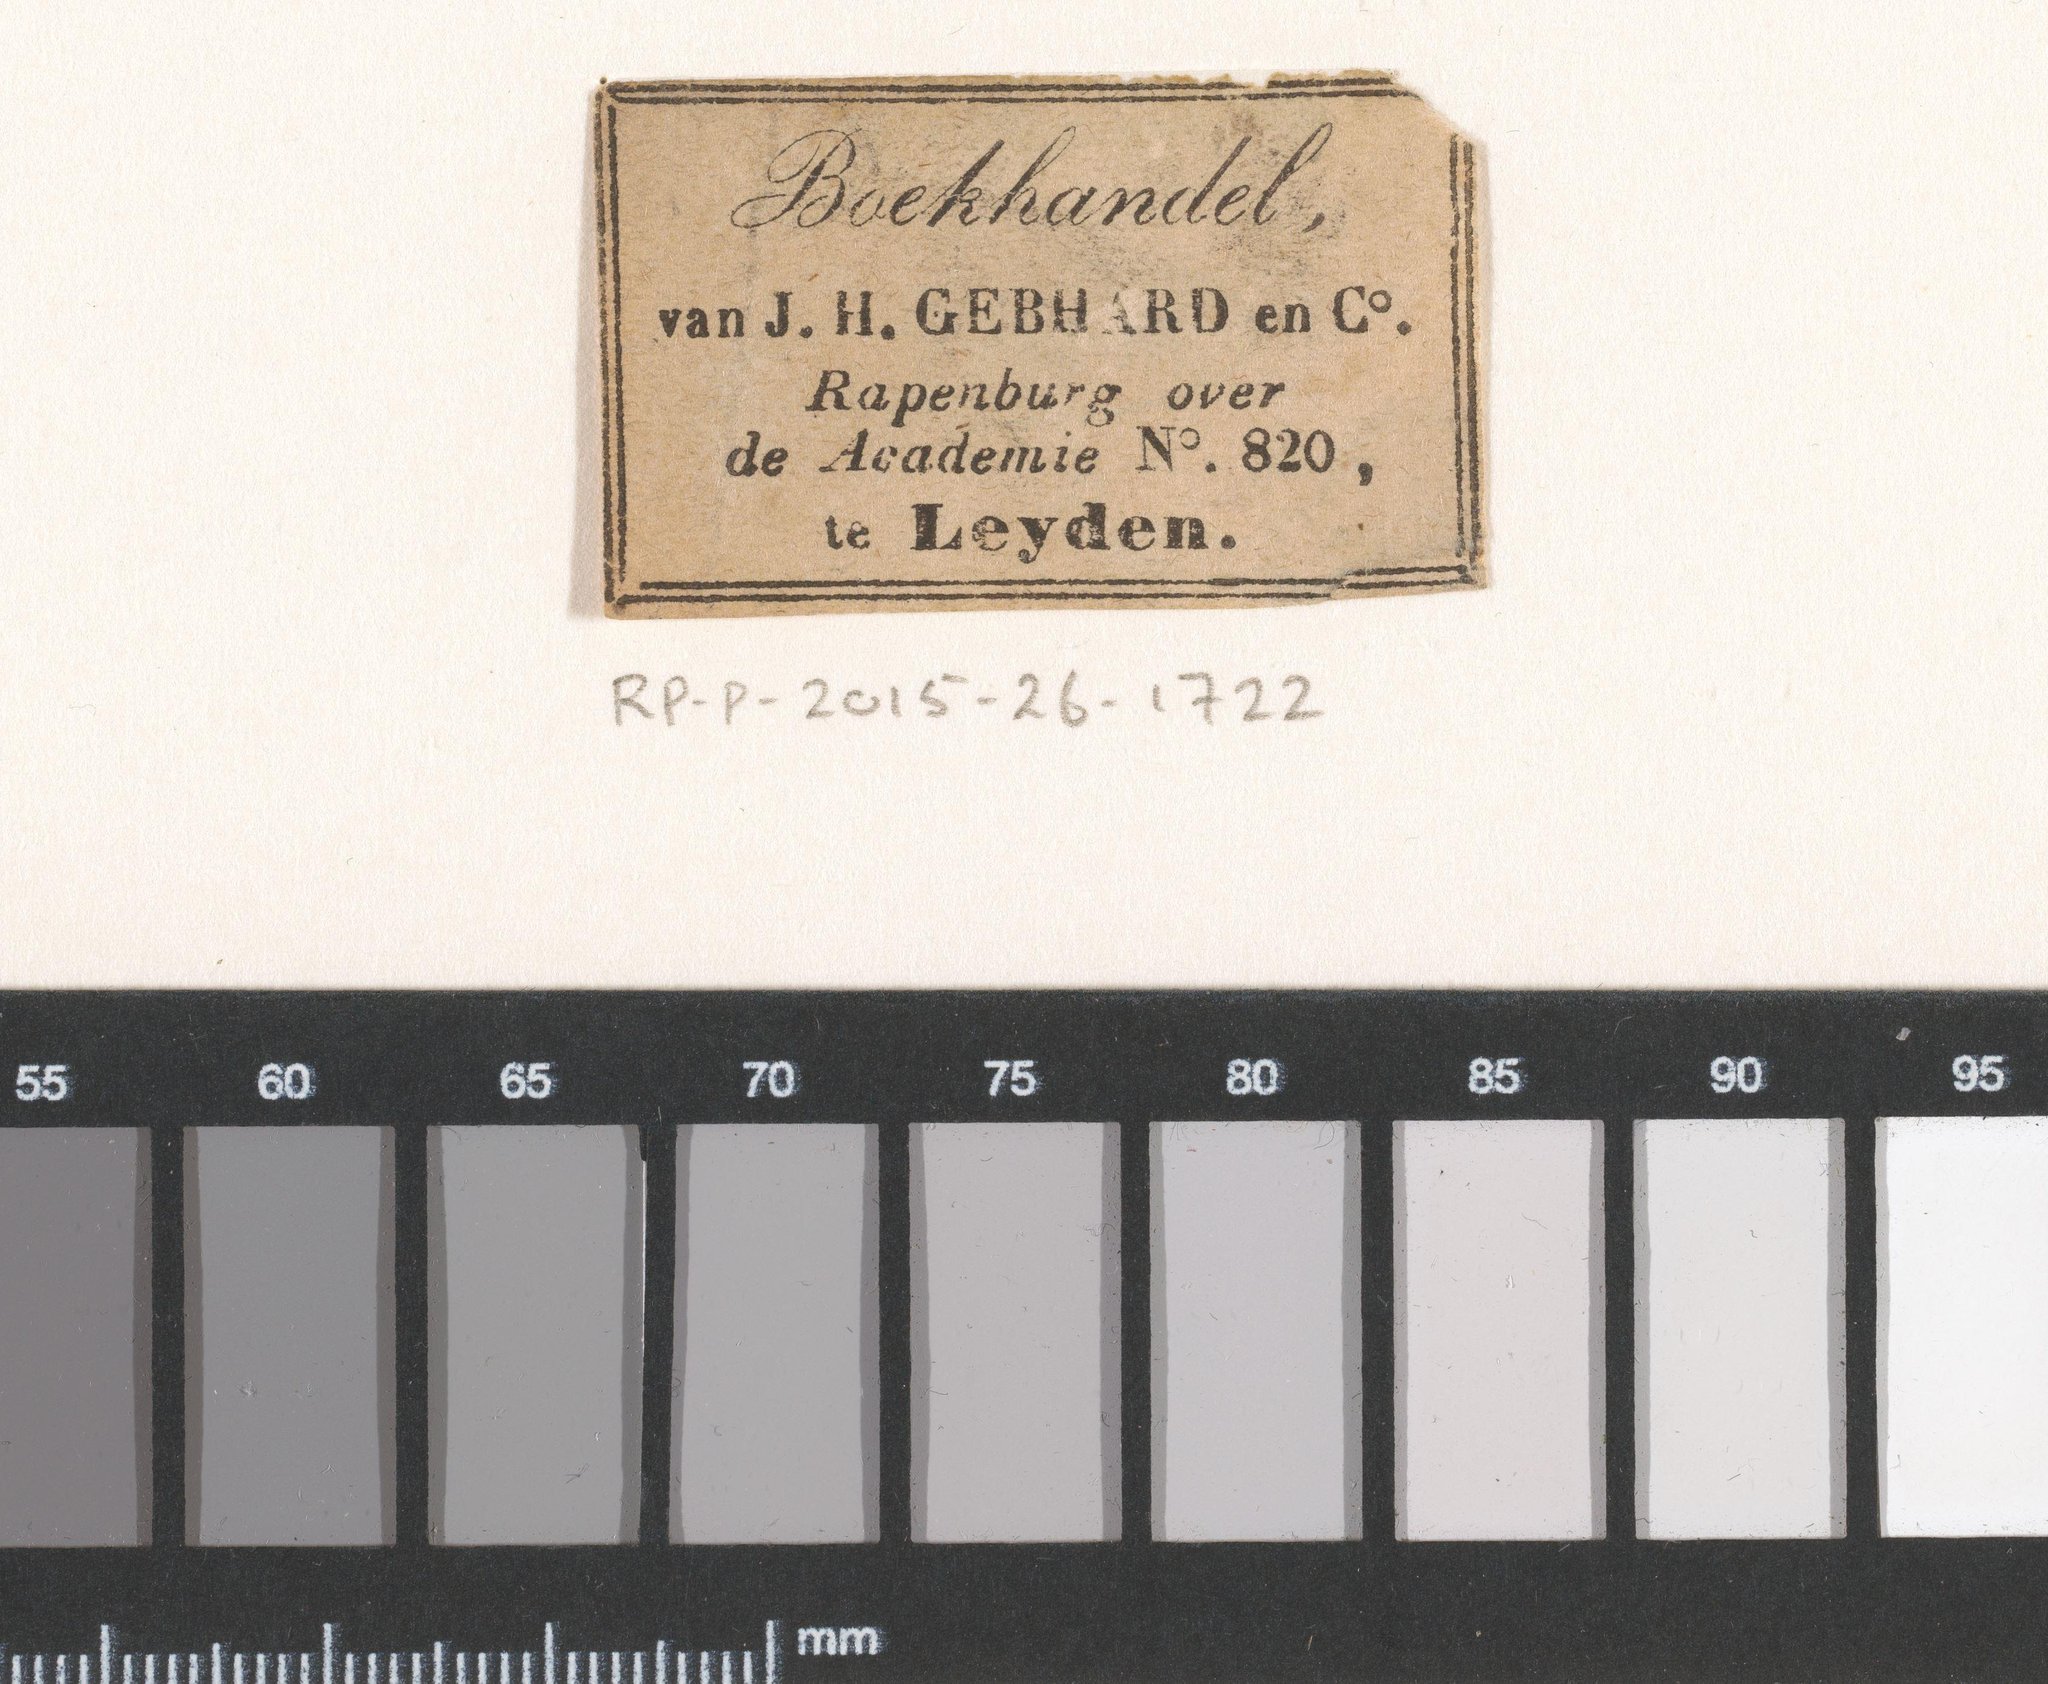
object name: boekhandelsetiket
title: Boekhandelsetiket van boekhandel J.H. Gebhard en Co. te Leiden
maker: Anonymous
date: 1837-1851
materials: paper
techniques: lithograph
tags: leiden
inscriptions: collector's mark: Lugt 2228